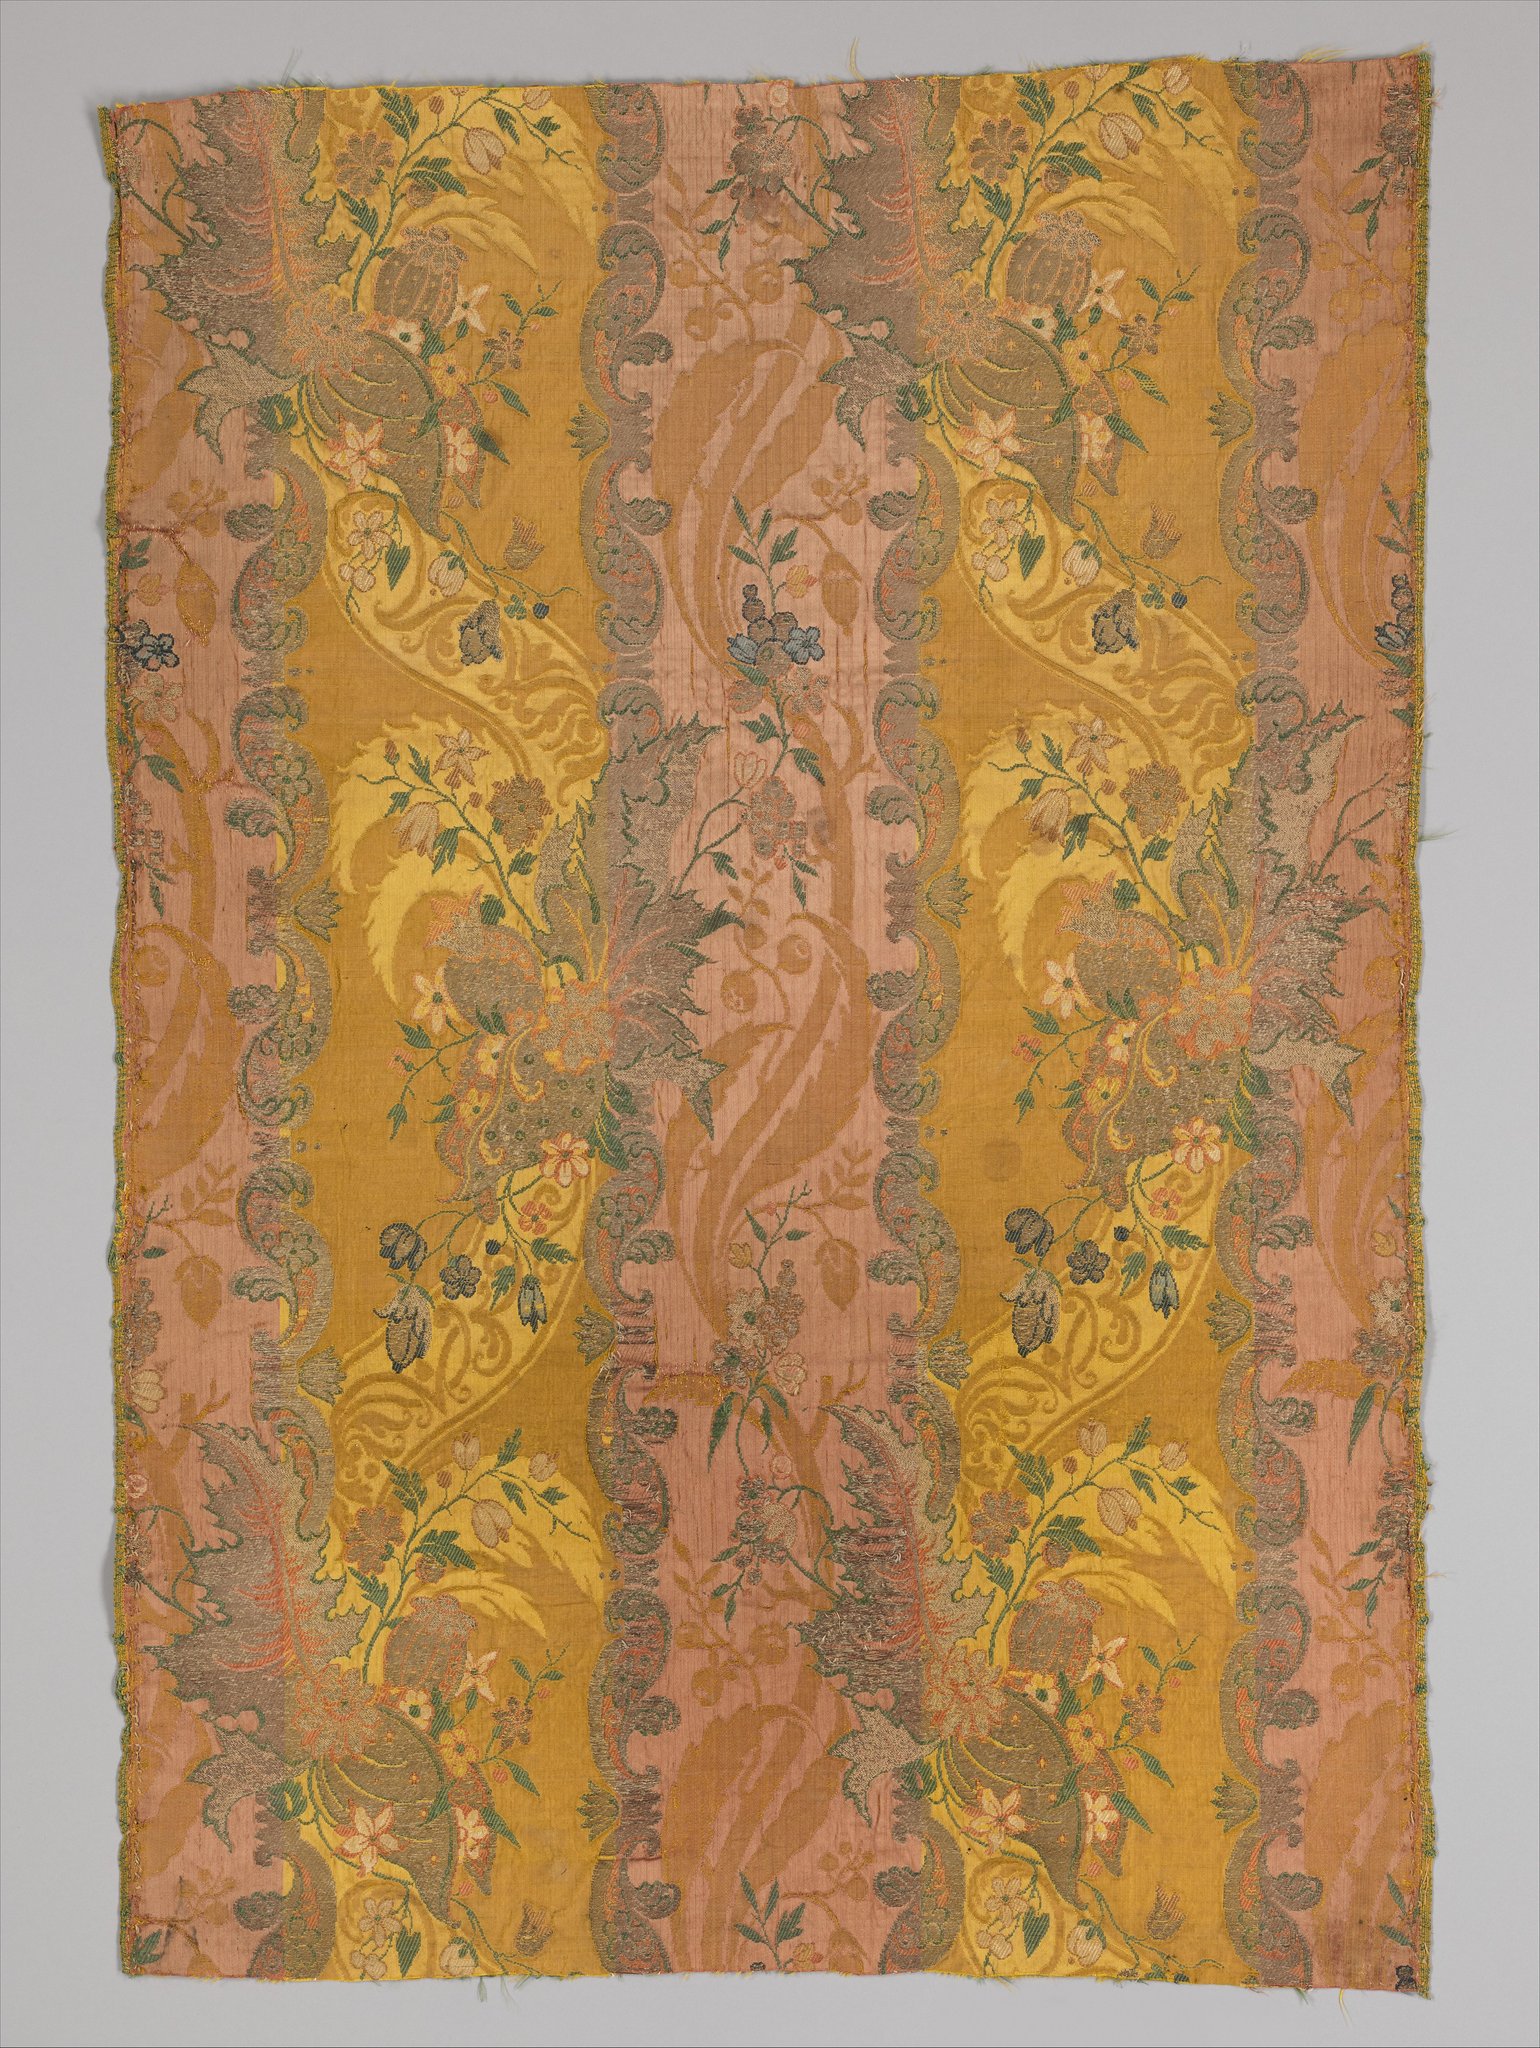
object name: piece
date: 1715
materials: metal thread, silk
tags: flowers,leaves